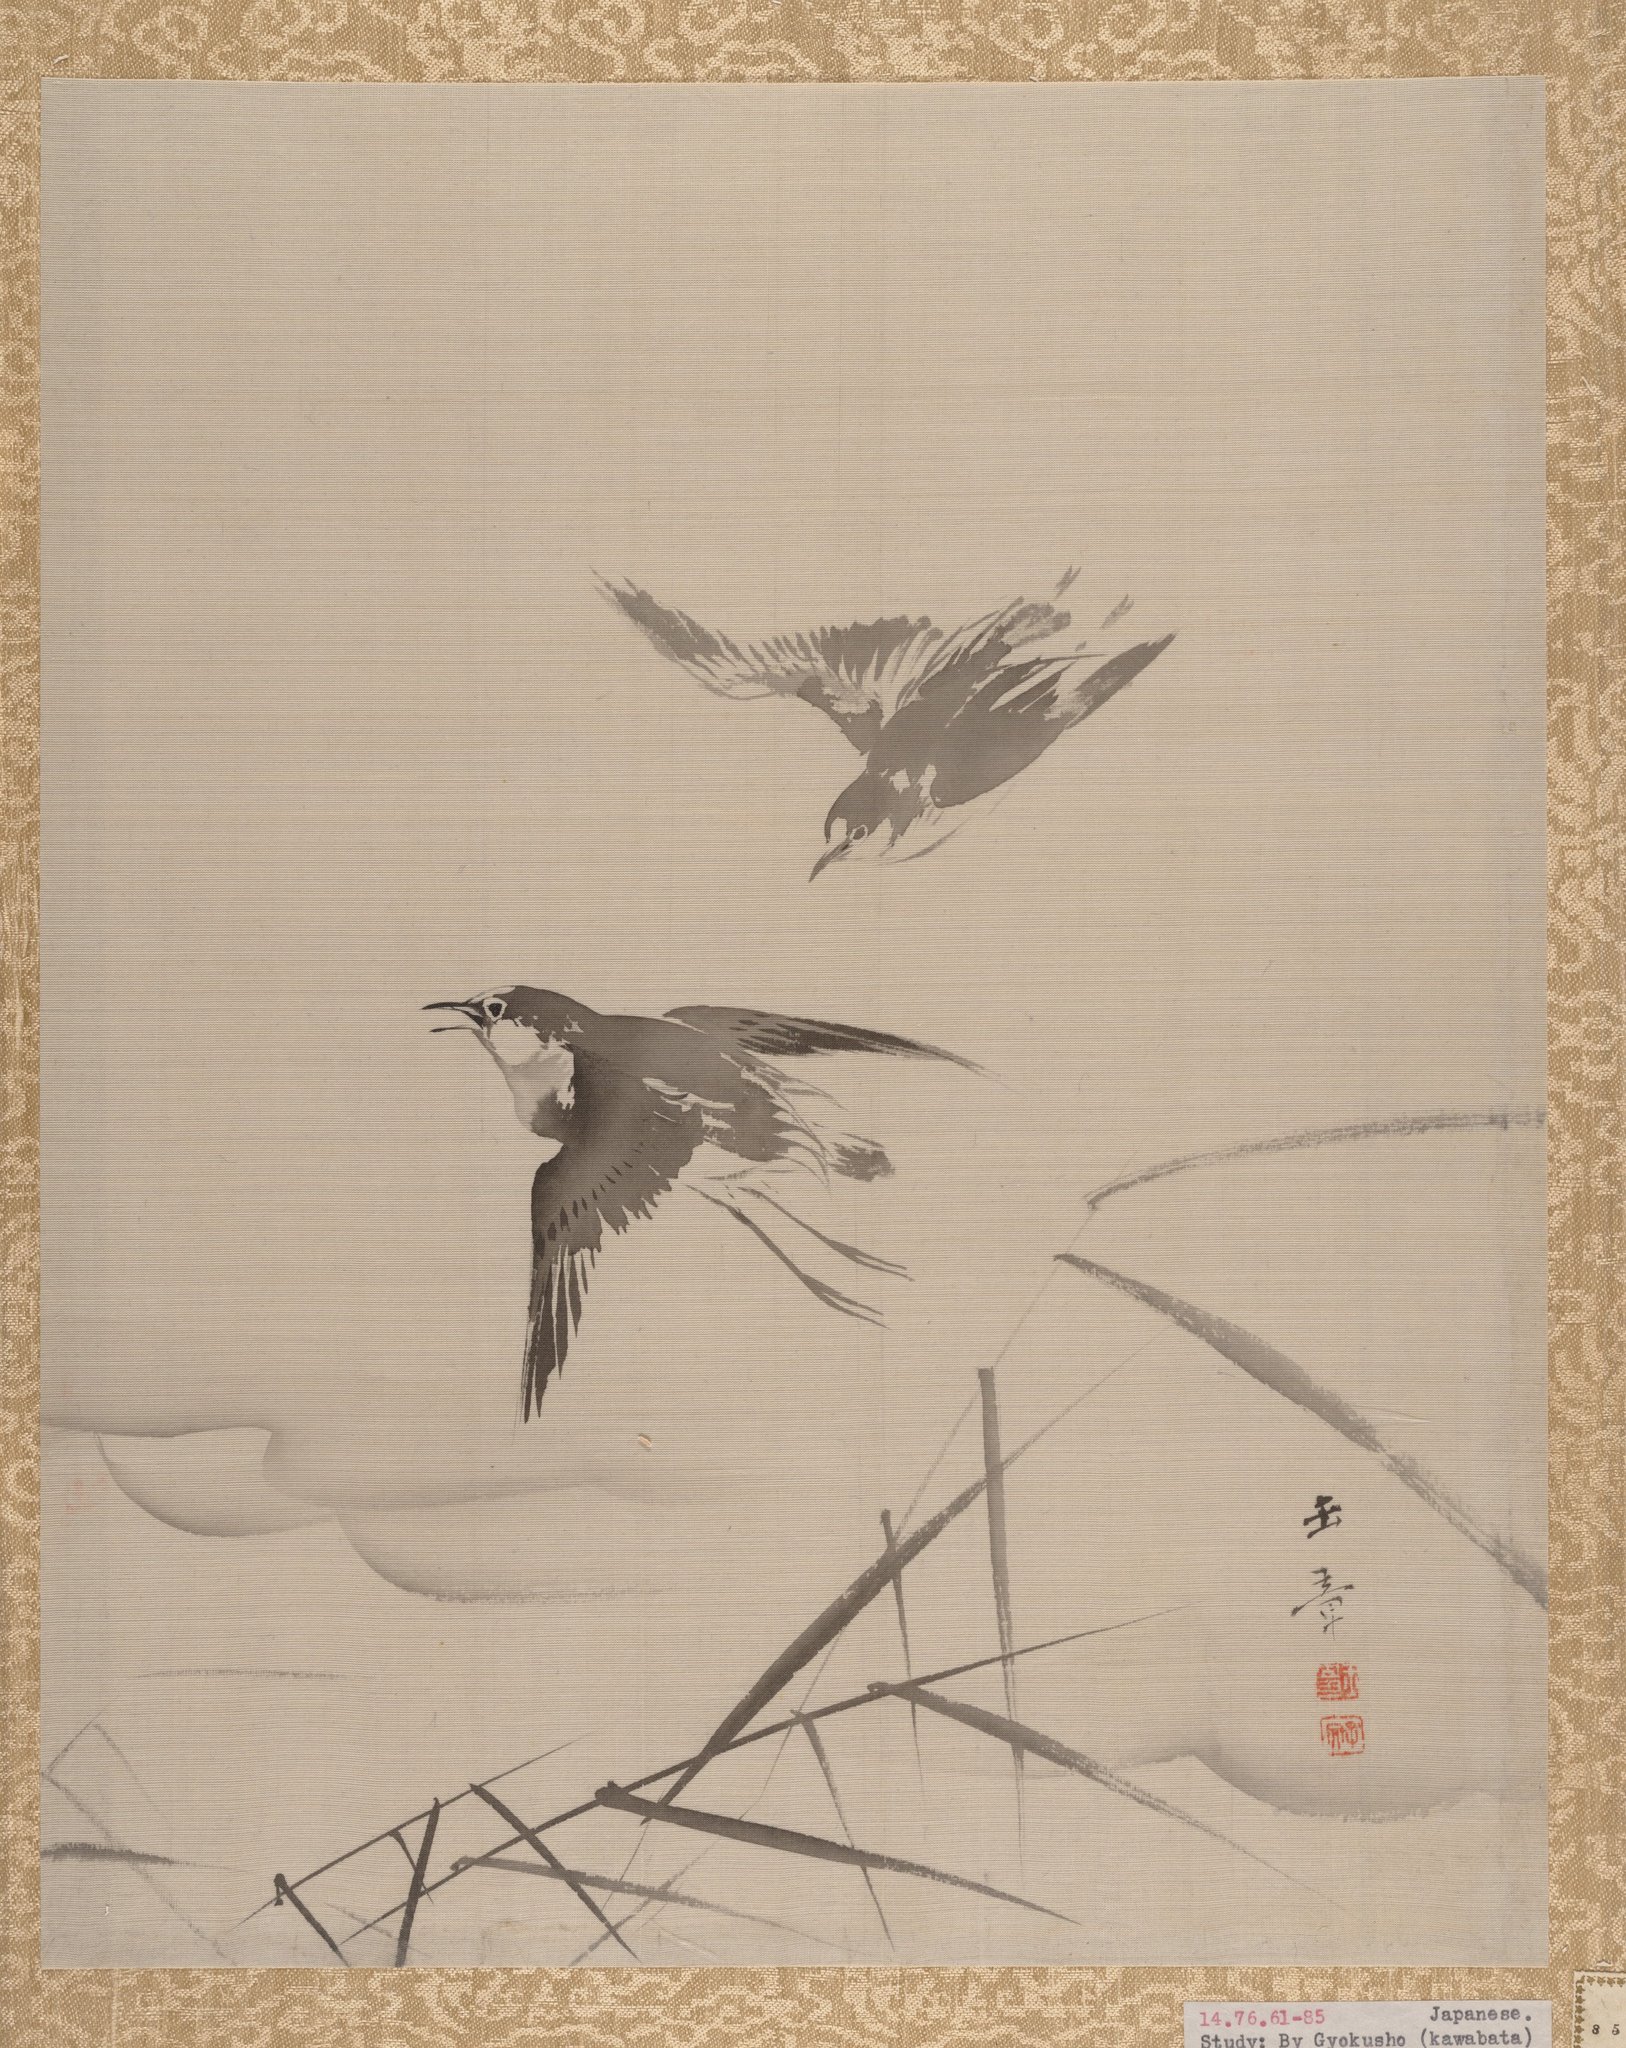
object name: album leaf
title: Small Birds and Bamboo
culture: japanese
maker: kawabata gyokushō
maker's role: artist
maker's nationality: japanese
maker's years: 1842-1913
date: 1887-1892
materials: ink, silk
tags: birds